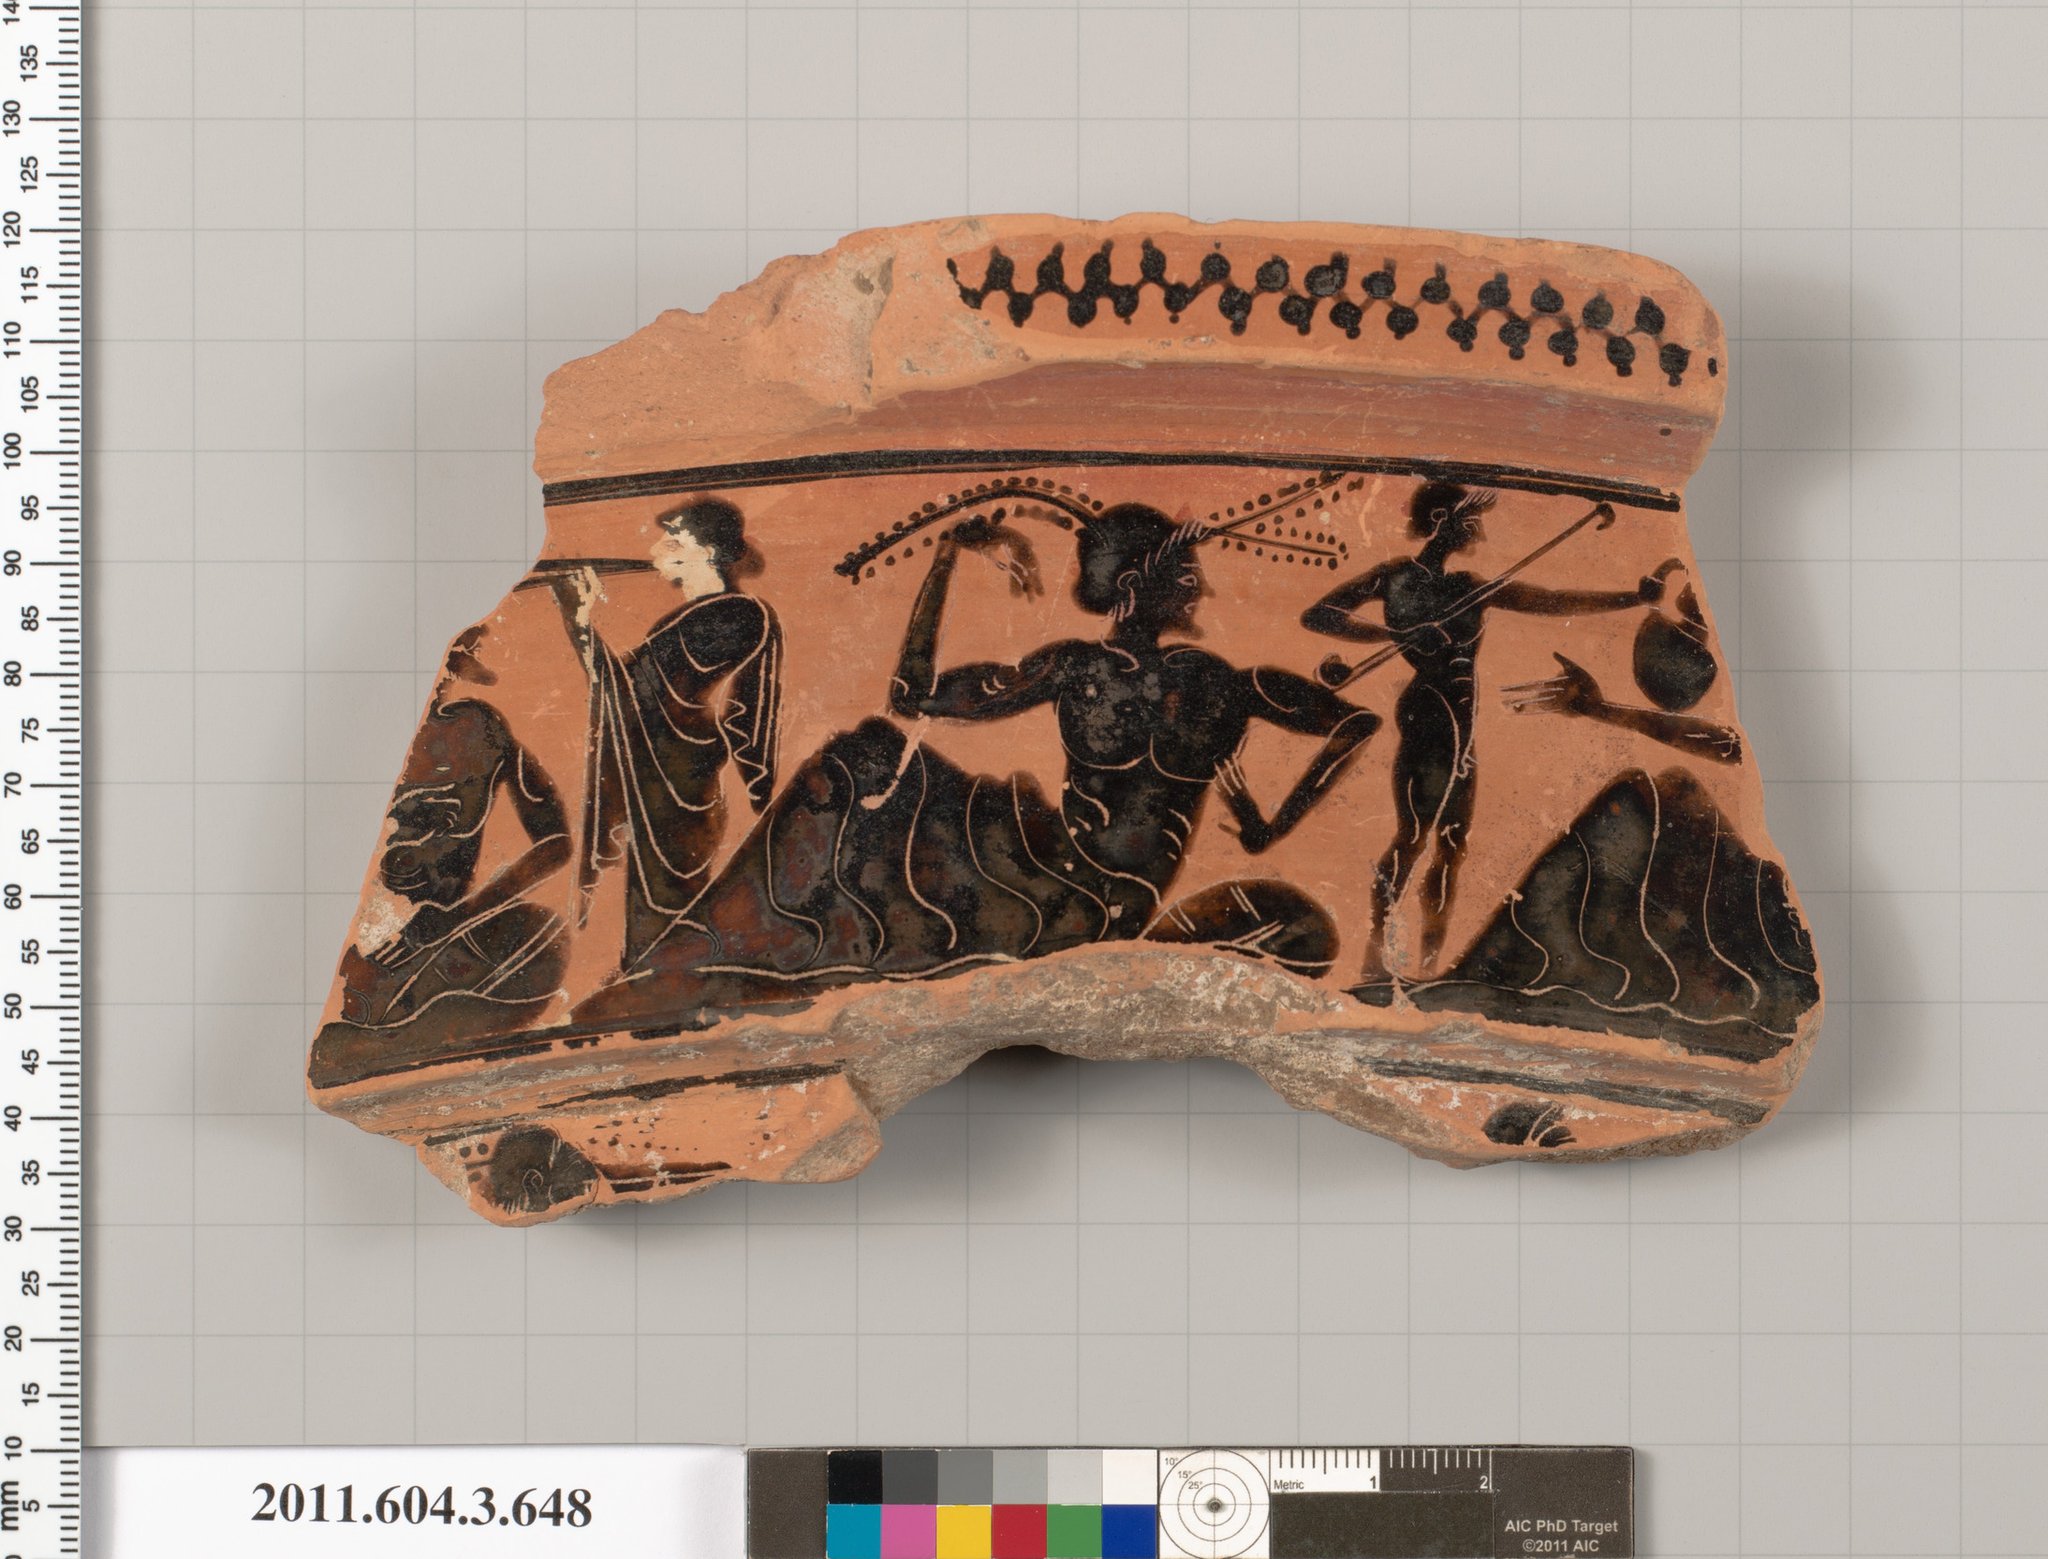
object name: volute krater fragment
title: Terracotta fragment of a volute-krater (bowl for mixing wine and water)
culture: greek, attic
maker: theseus painter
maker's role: artist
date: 500 BCE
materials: terracotta